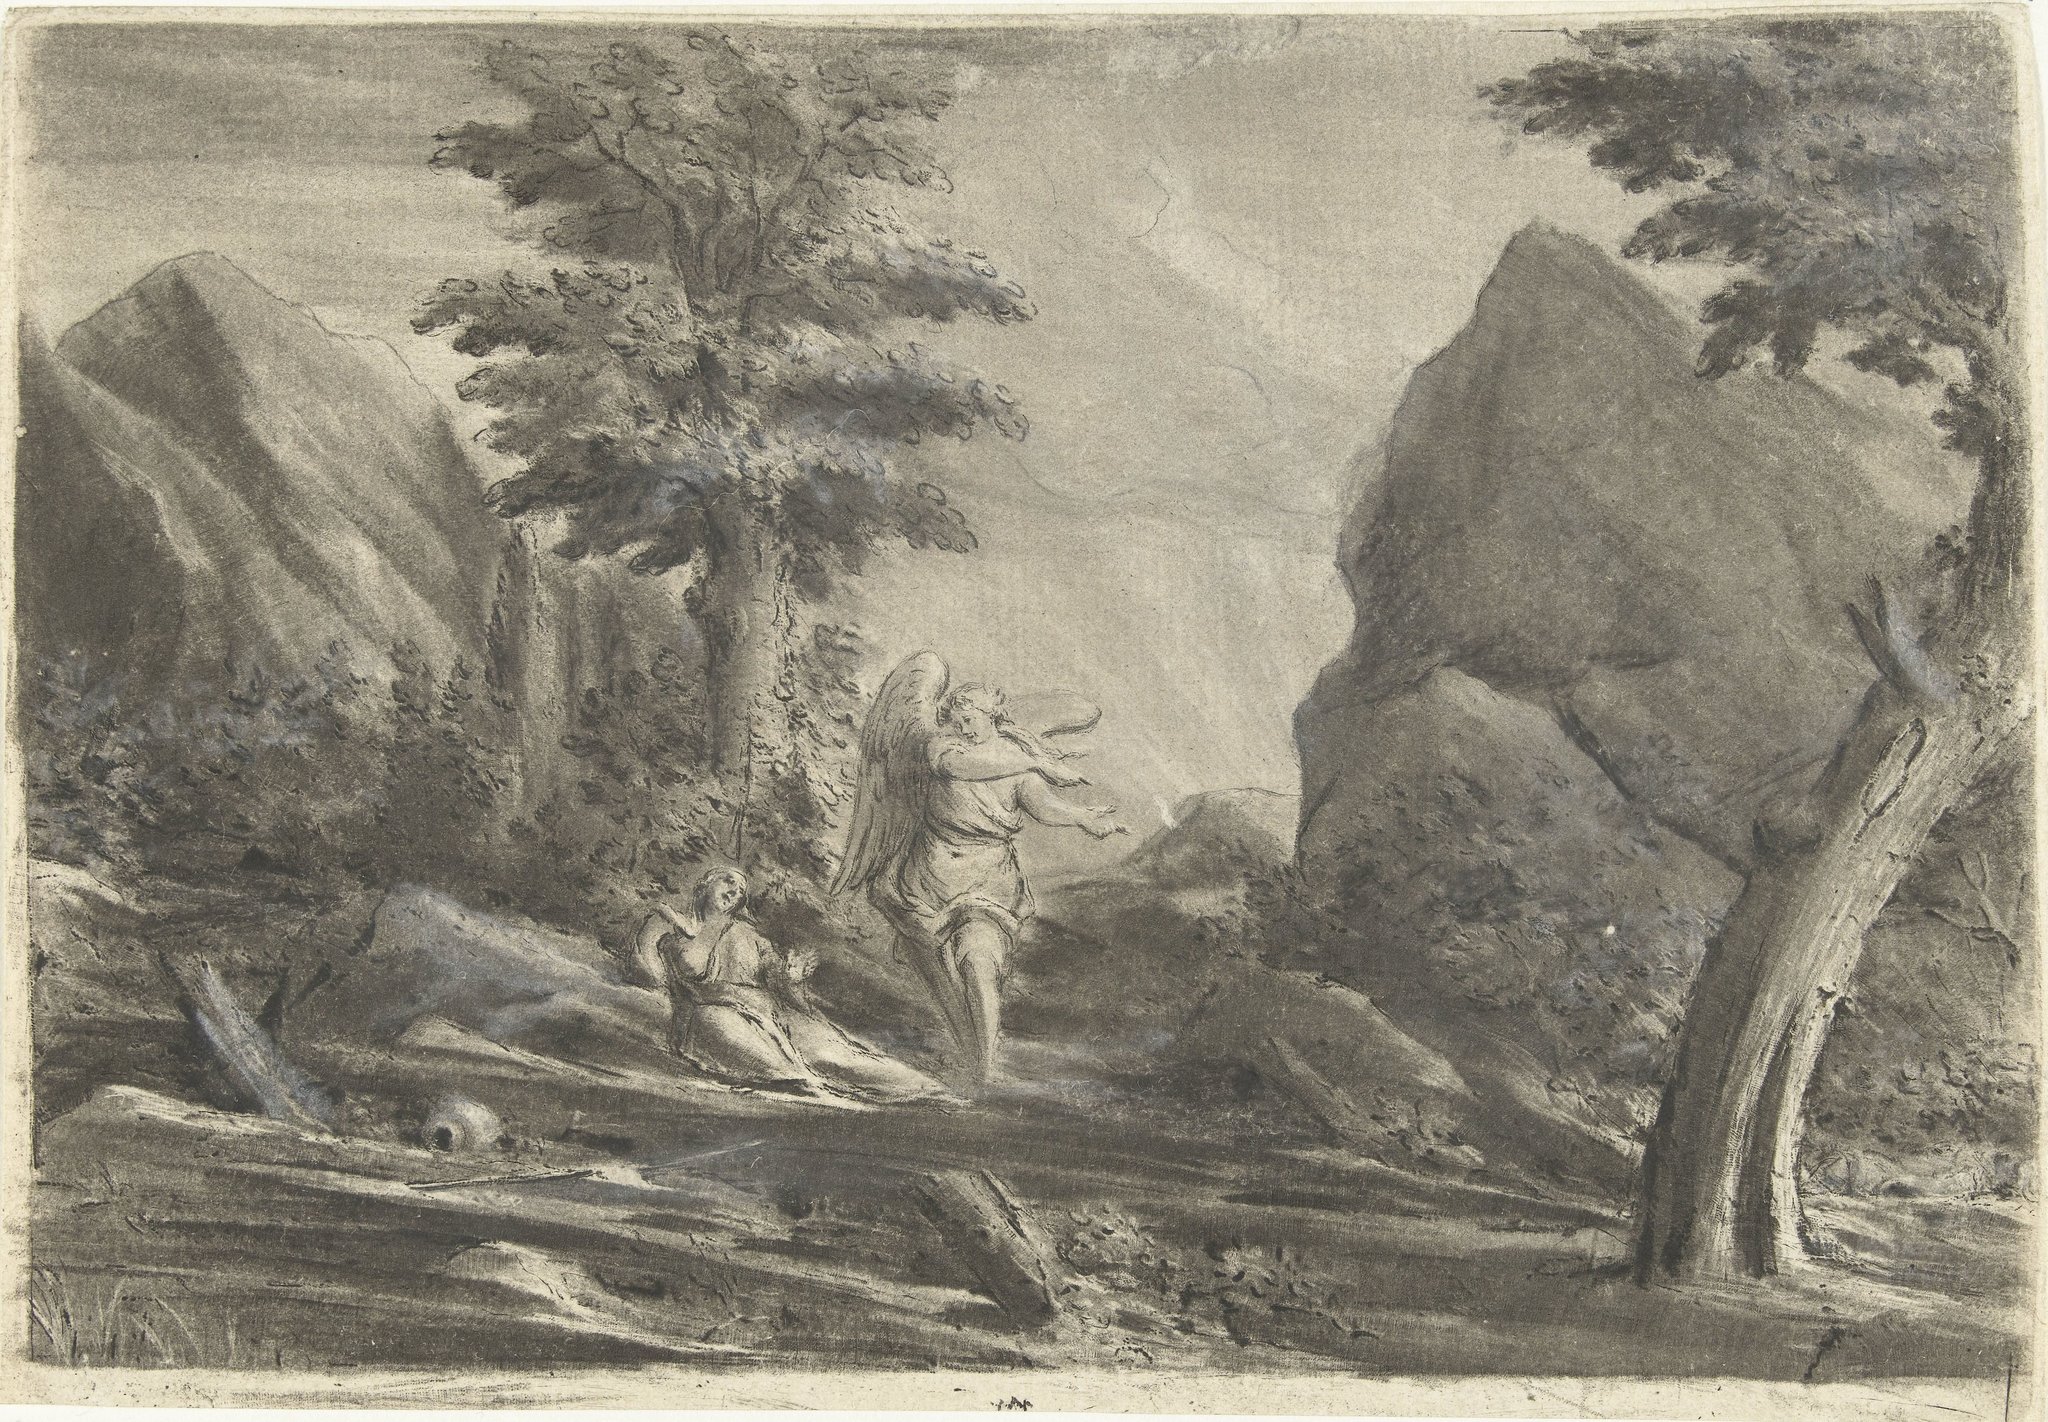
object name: print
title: Hagar in de woestijn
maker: jurriaan cootwijck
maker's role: print maker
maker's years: 1714-1798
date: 1759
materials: paper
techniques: print drawing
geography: amsterdam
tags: an angel appears and reveals a well of water to hagar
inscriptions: collector's mark: Lugt 2228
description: Hagar ligt op de grond in een bergachtig landschap. Een engel wijst haar naar een waterbron.